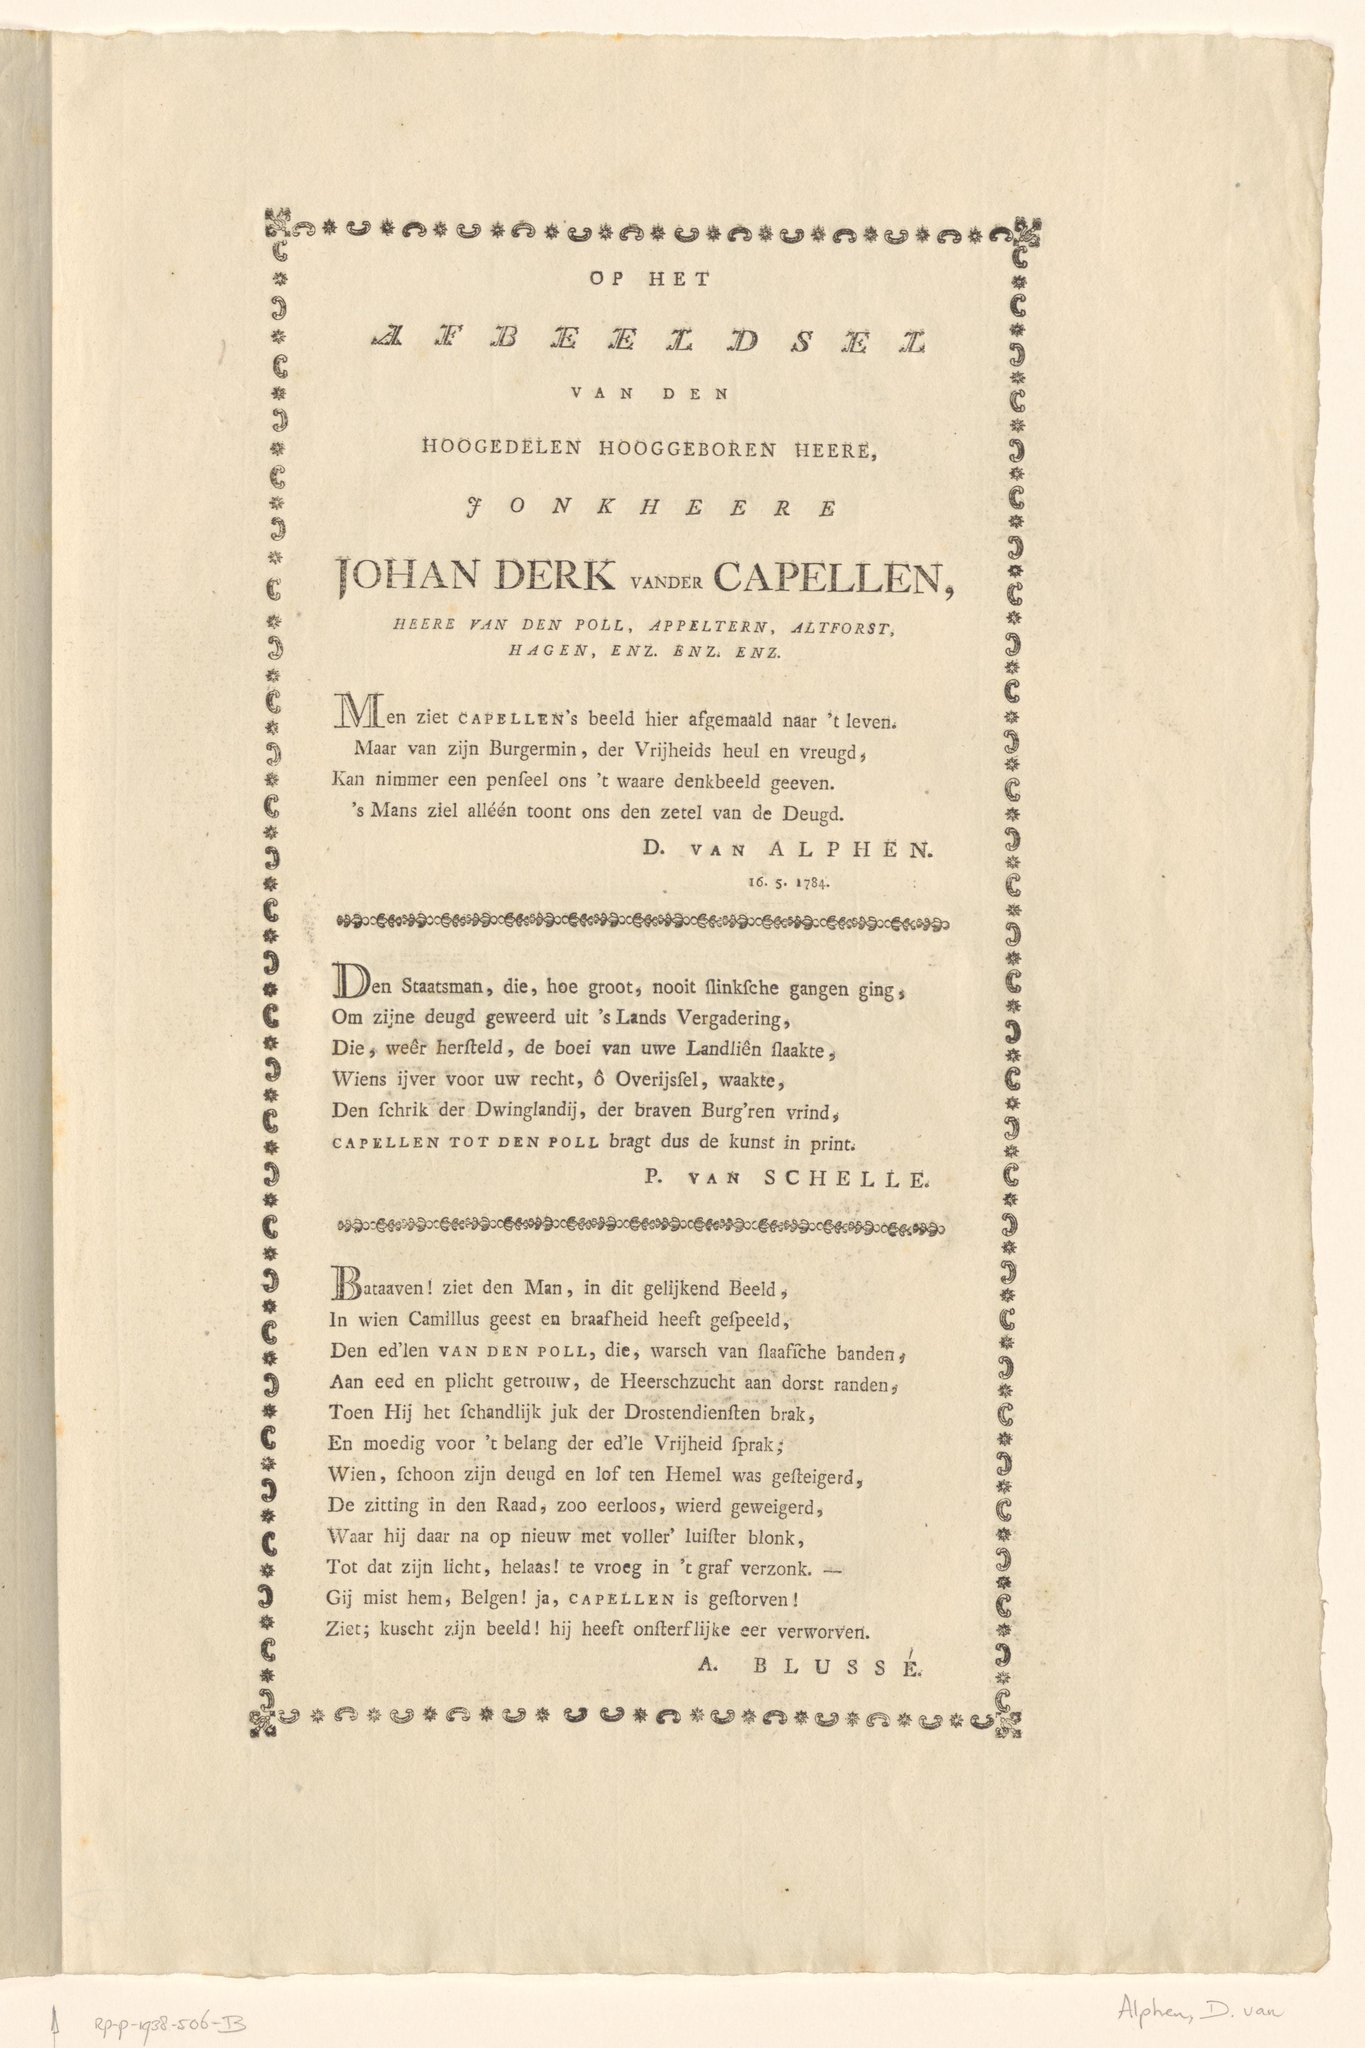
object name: text sheet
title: Vier lofdichten op de politicus Joan Derk van der Capellen tot den Pol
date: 1785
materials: paper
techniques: letterpress printing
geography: leiden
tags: politician, joan derk van der capellen tot den pol, historical persons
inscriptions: date